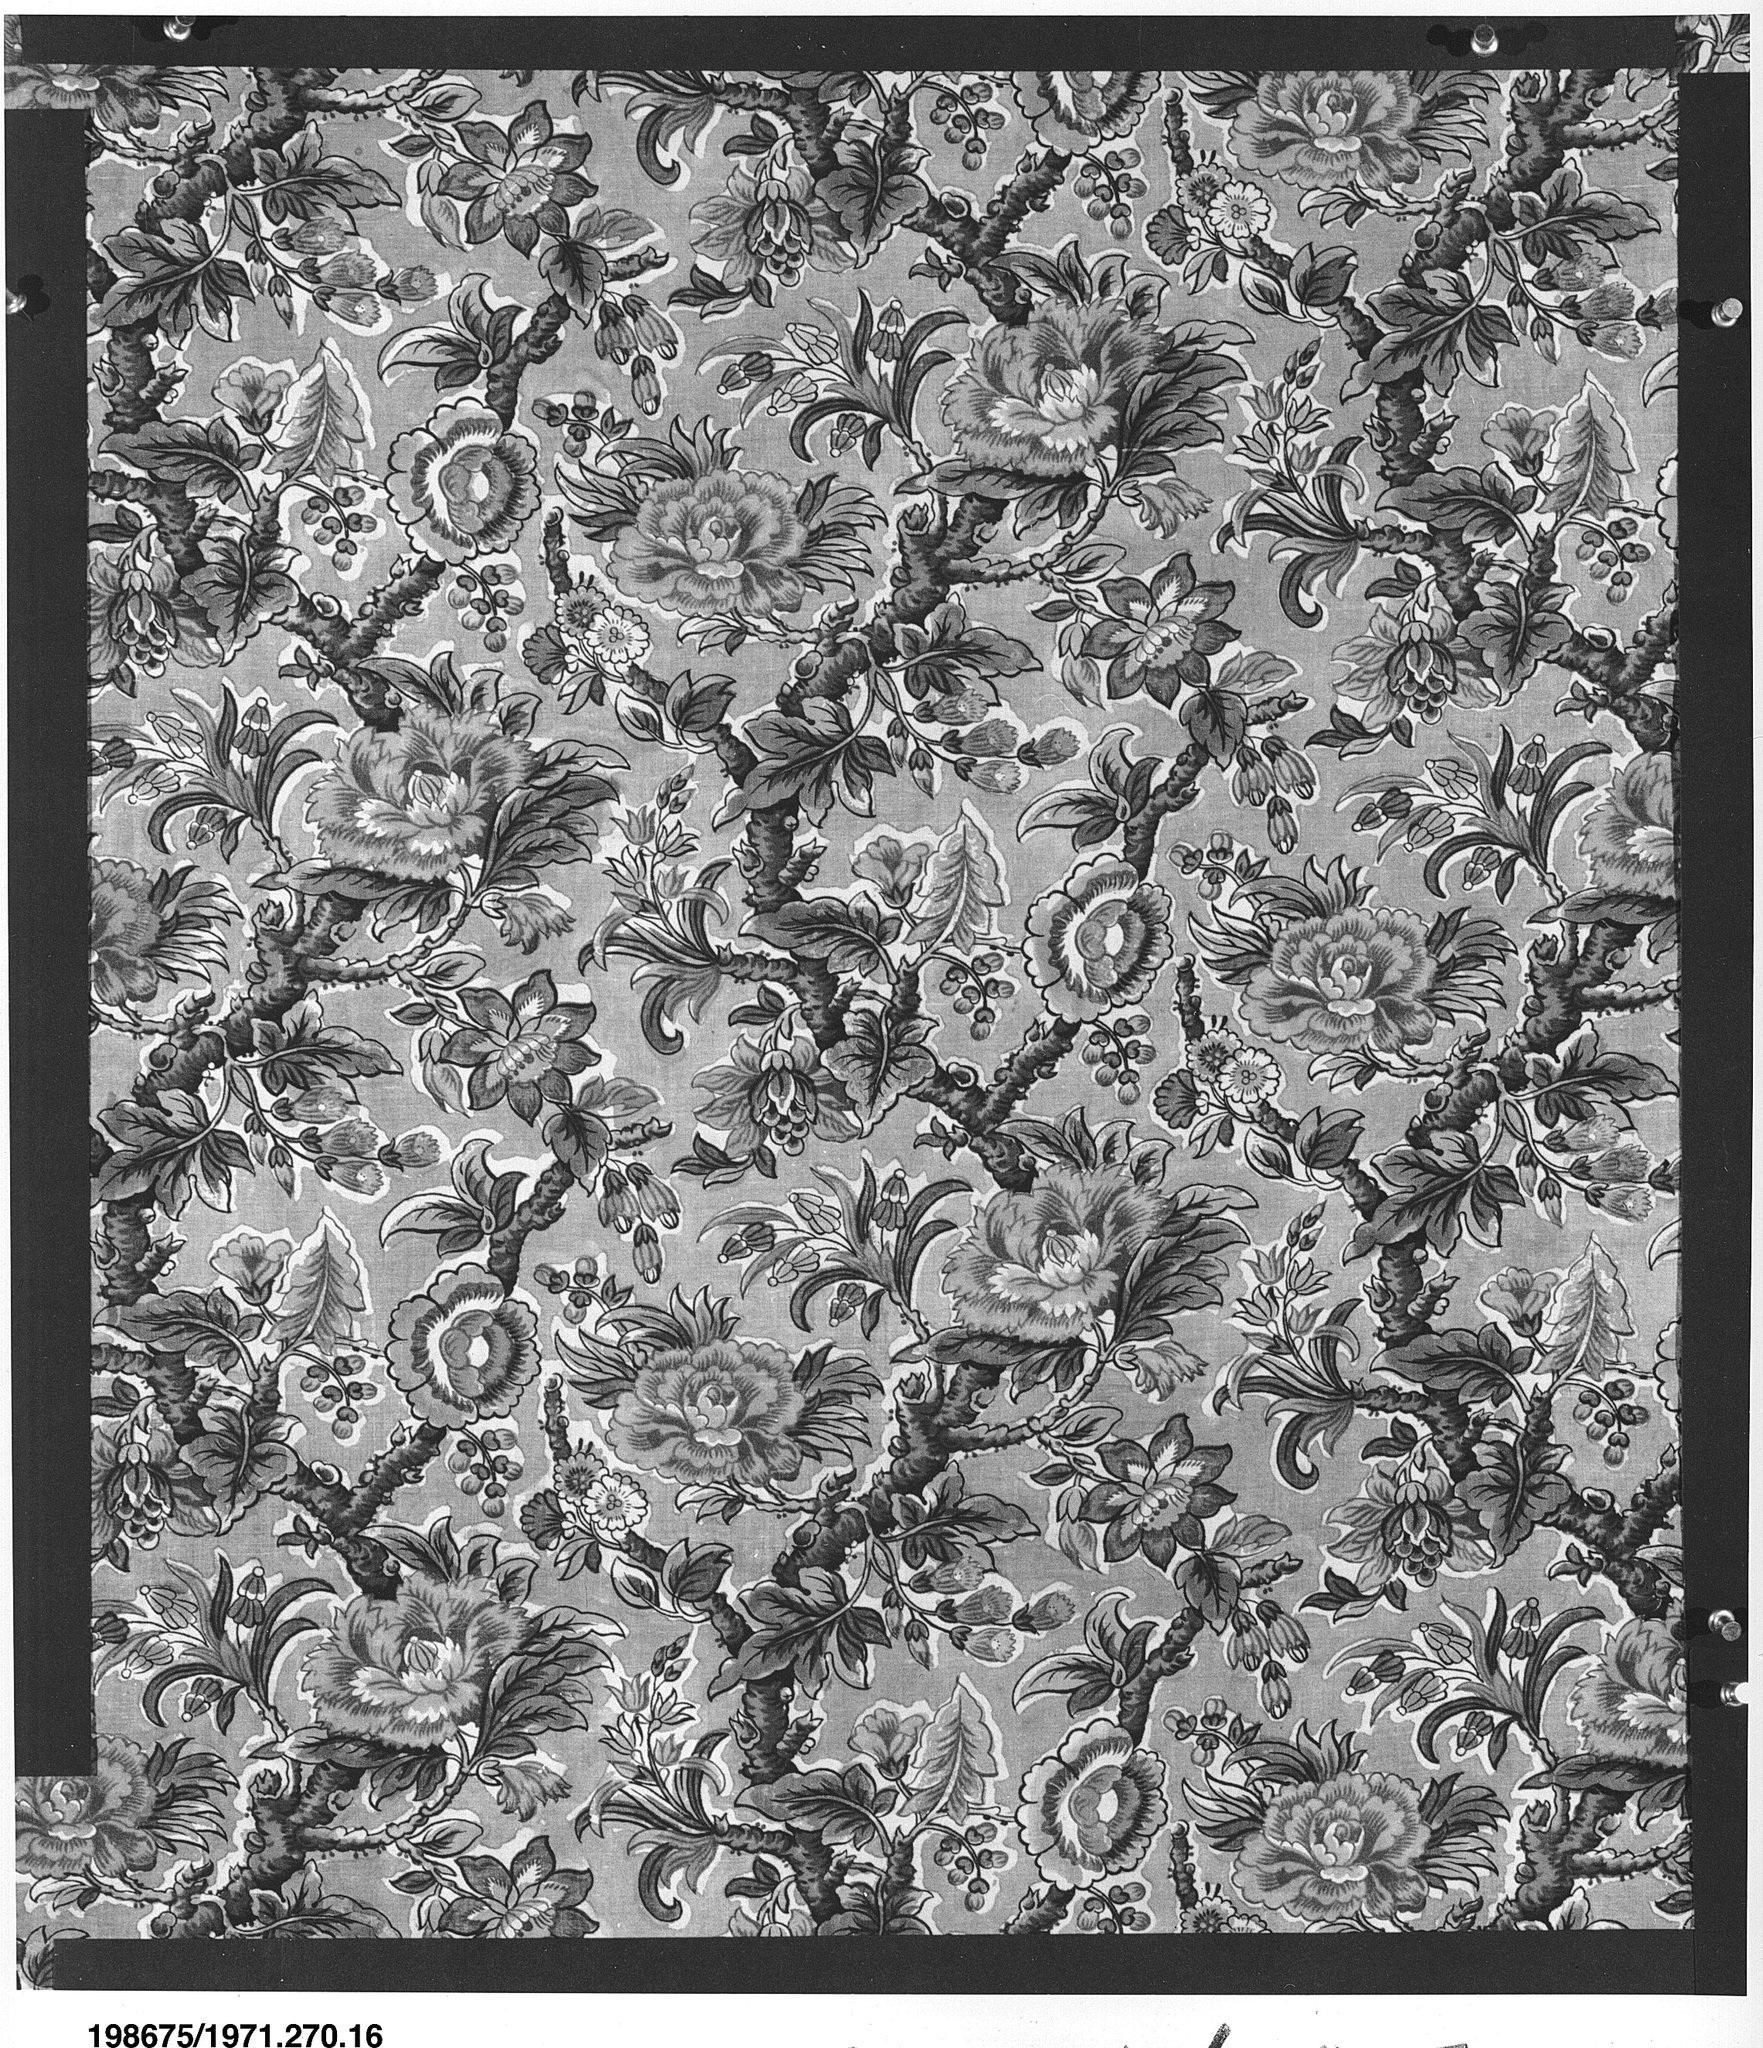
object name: piece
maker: bannister hall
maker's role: manufactory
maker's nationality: british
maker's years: 1793-1893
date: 1810-1815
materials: cotton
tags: flowers,leaves